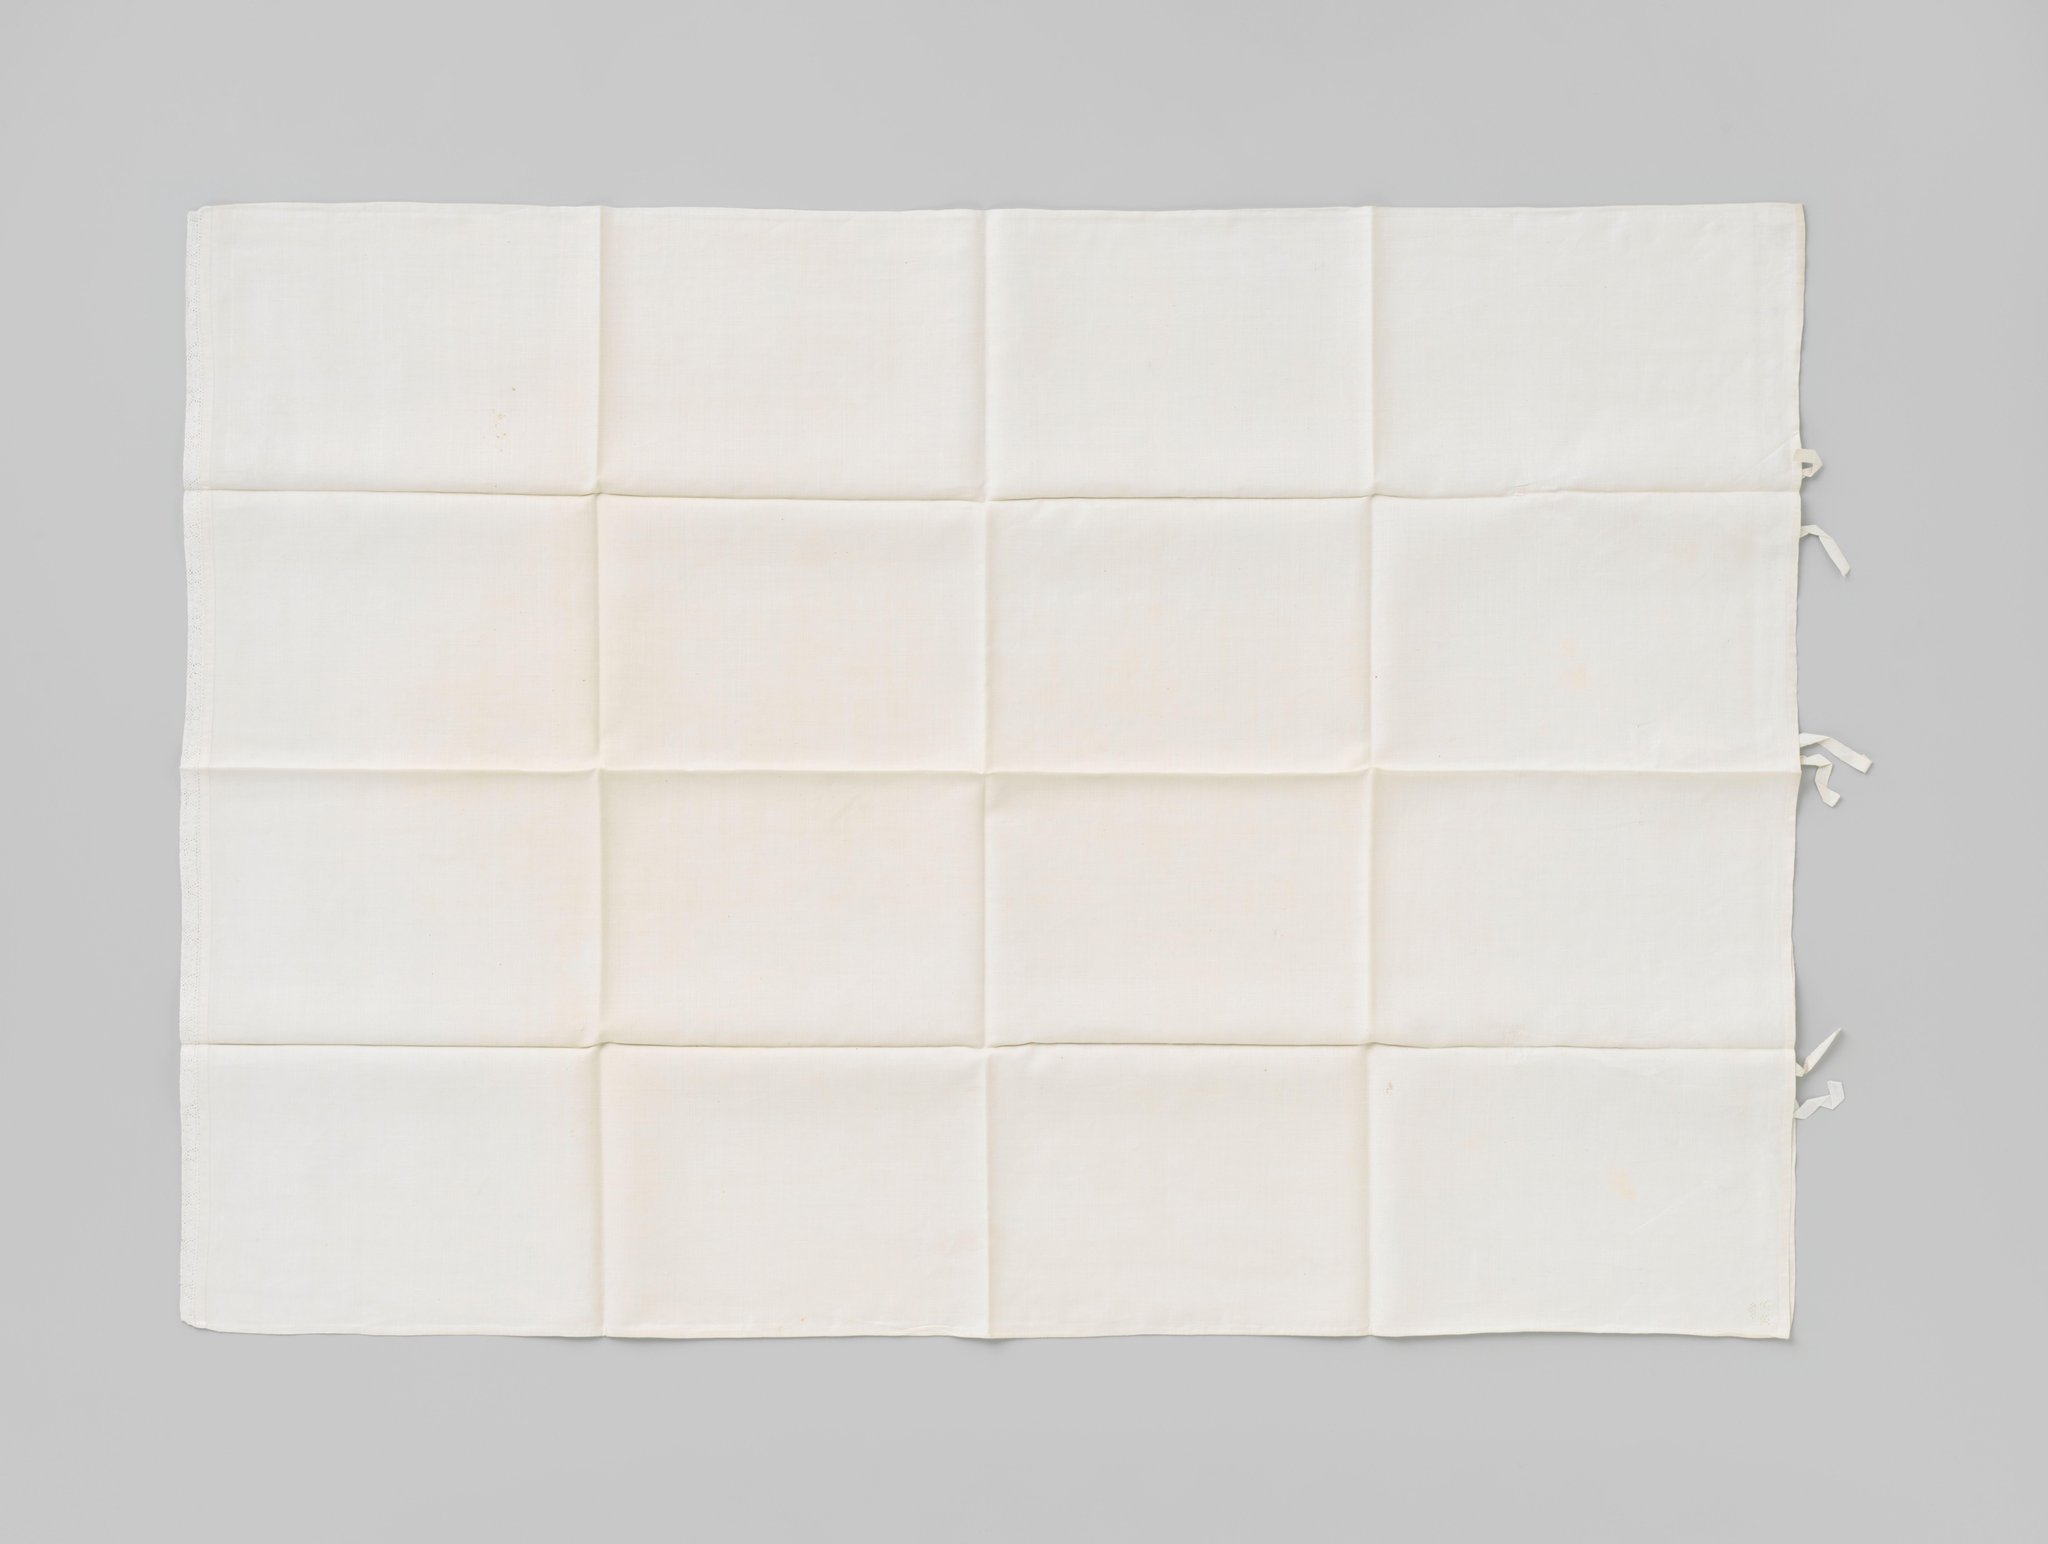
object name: sloop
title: Kussensloop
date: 1650-1700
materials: linen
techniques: lace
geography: northern netherlands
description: Kussensloop van linnen met kloskant aan een uiteinde. Gemerkt kroon RR.